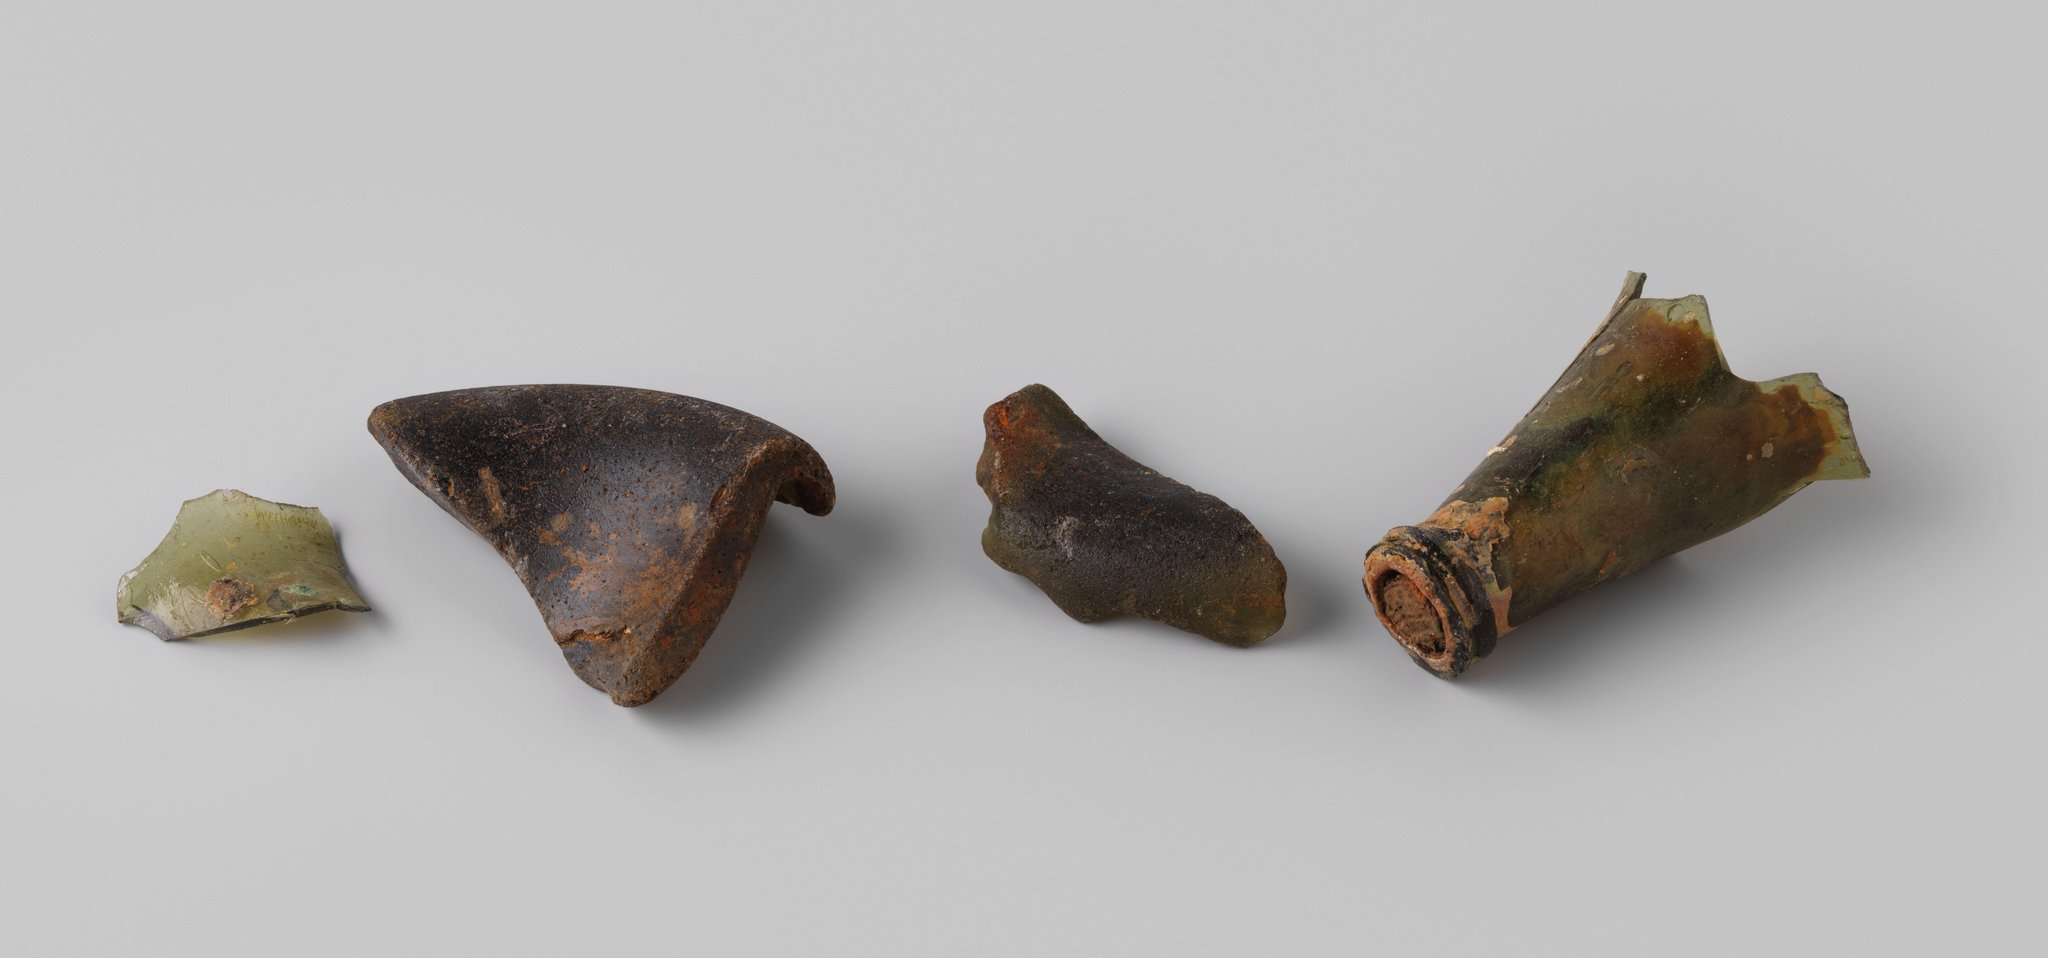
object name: sherd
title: Hals met kurk van een wijnfles en glasscherven uit het wrak van de Oost-Indiëvaarder Hollandia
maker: Anonymous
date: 1700-1743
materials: cork, glass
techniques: green glass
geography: netherlands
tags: verenigde oostindische compagnie, hollandia (schip), annet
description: Typologically not identifiable, base, fragm.